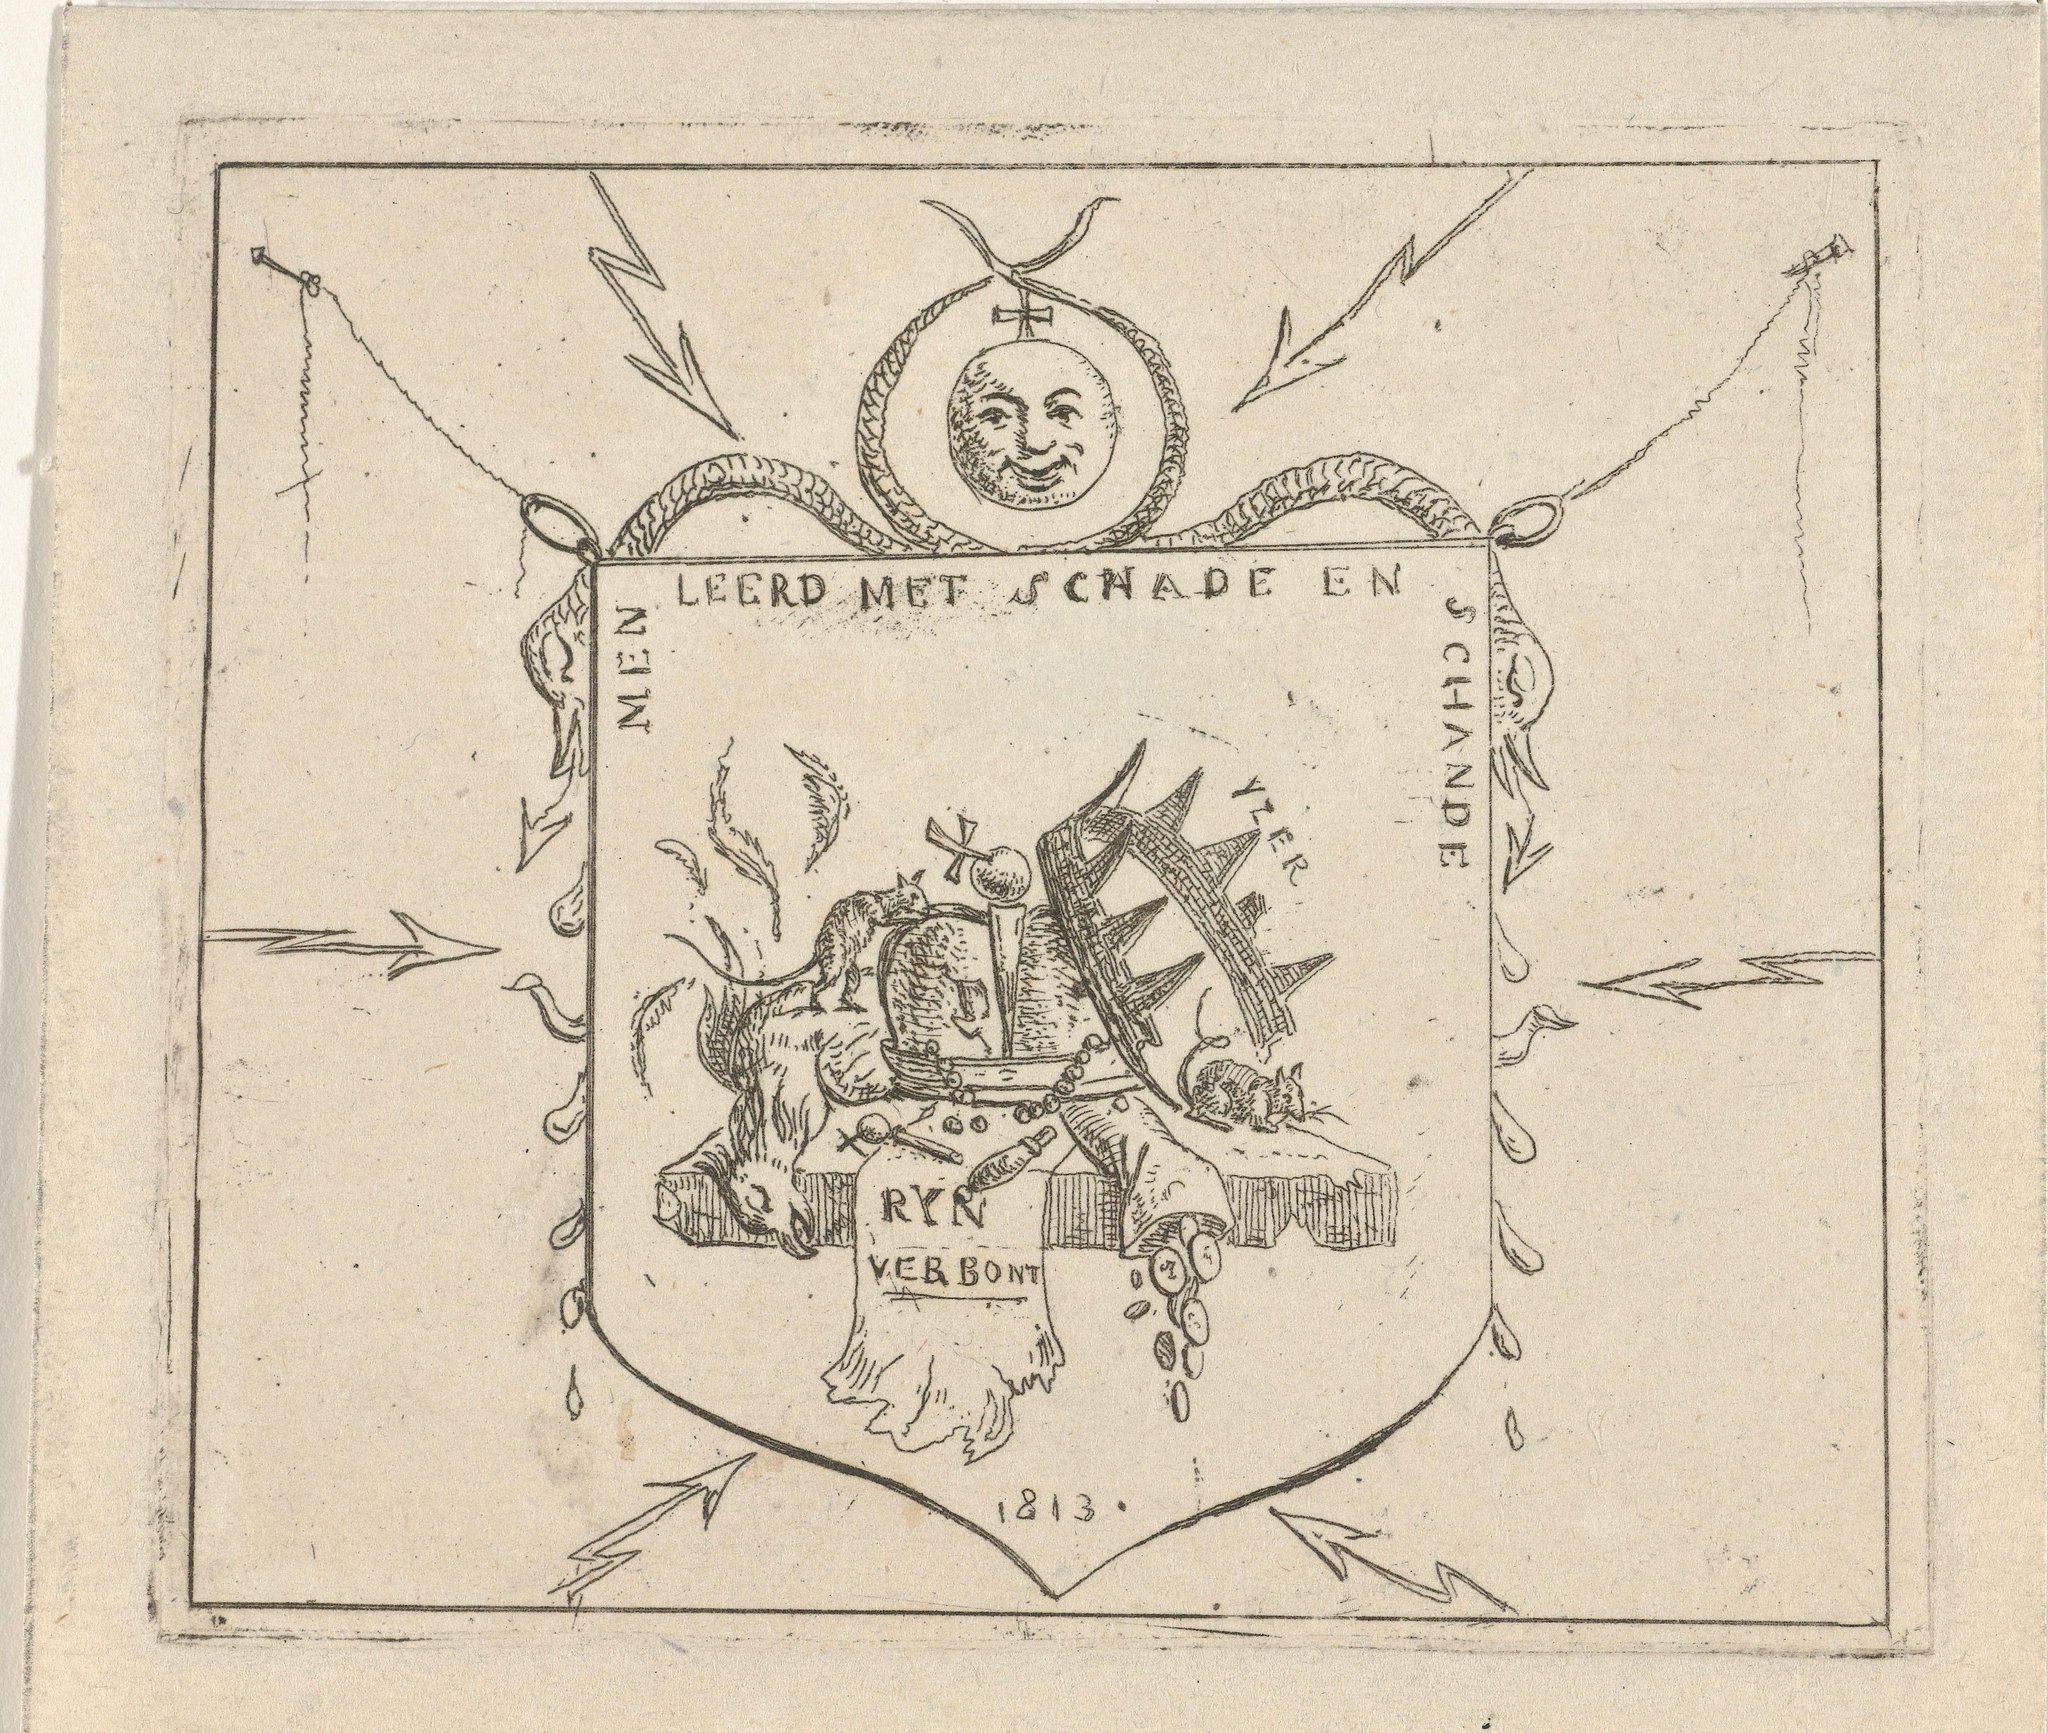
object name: cartoon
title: Spotprenten op de nederlagen der Fransen in 1813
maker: hermanus fock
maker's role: conservator, draughtsman, painter, print maker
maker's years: 1766-1822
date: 1813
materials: paper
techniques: etching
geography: amsterdam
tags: armorial bearing, heraldry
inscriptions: collector's mark: Lugt 2760, collector's mark: Lugt 2228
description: Spotprent op de nederlaag der Franse troepen in de slag bij Leipzig. Kronen worden door muizen aangeknaagd. Een verscheurd vaandel van de Rijnbond ligt naast een dode vogel en een zakje met munten. Met tekst: Men leerd met schade en schande.